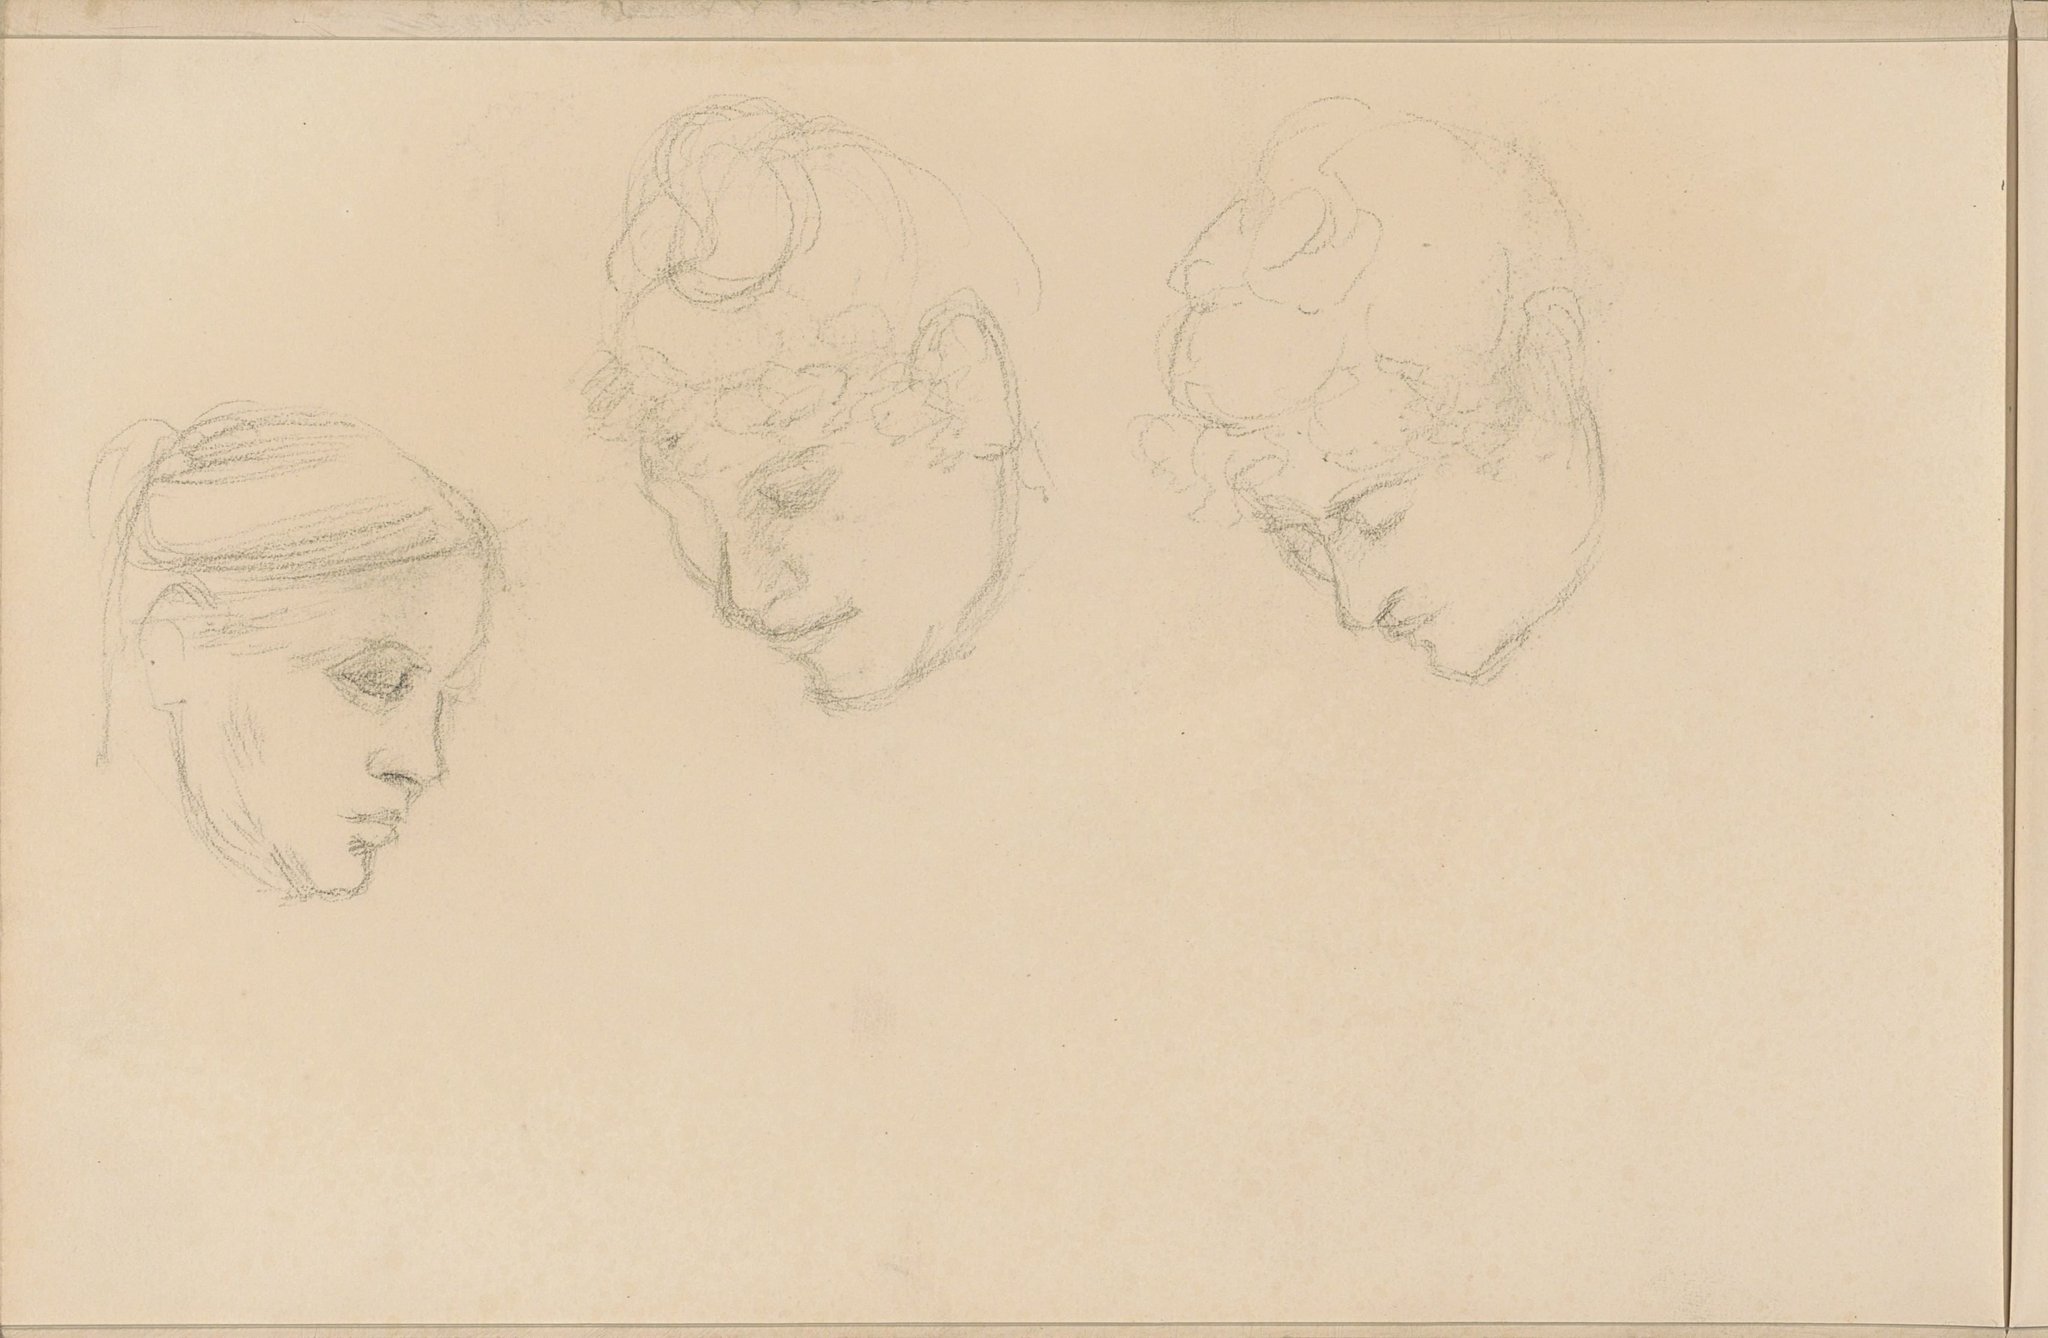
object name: sketchbook leaf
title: Vrouwenkop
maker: jozef israëls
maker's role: draughtsman, painter, print maker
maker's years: 1824-1911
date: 1834-1911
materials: chalk, paper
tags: head (human) (+ adult female (human being))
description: Blad 20 verso uit een schetsboek met 25 bladen.